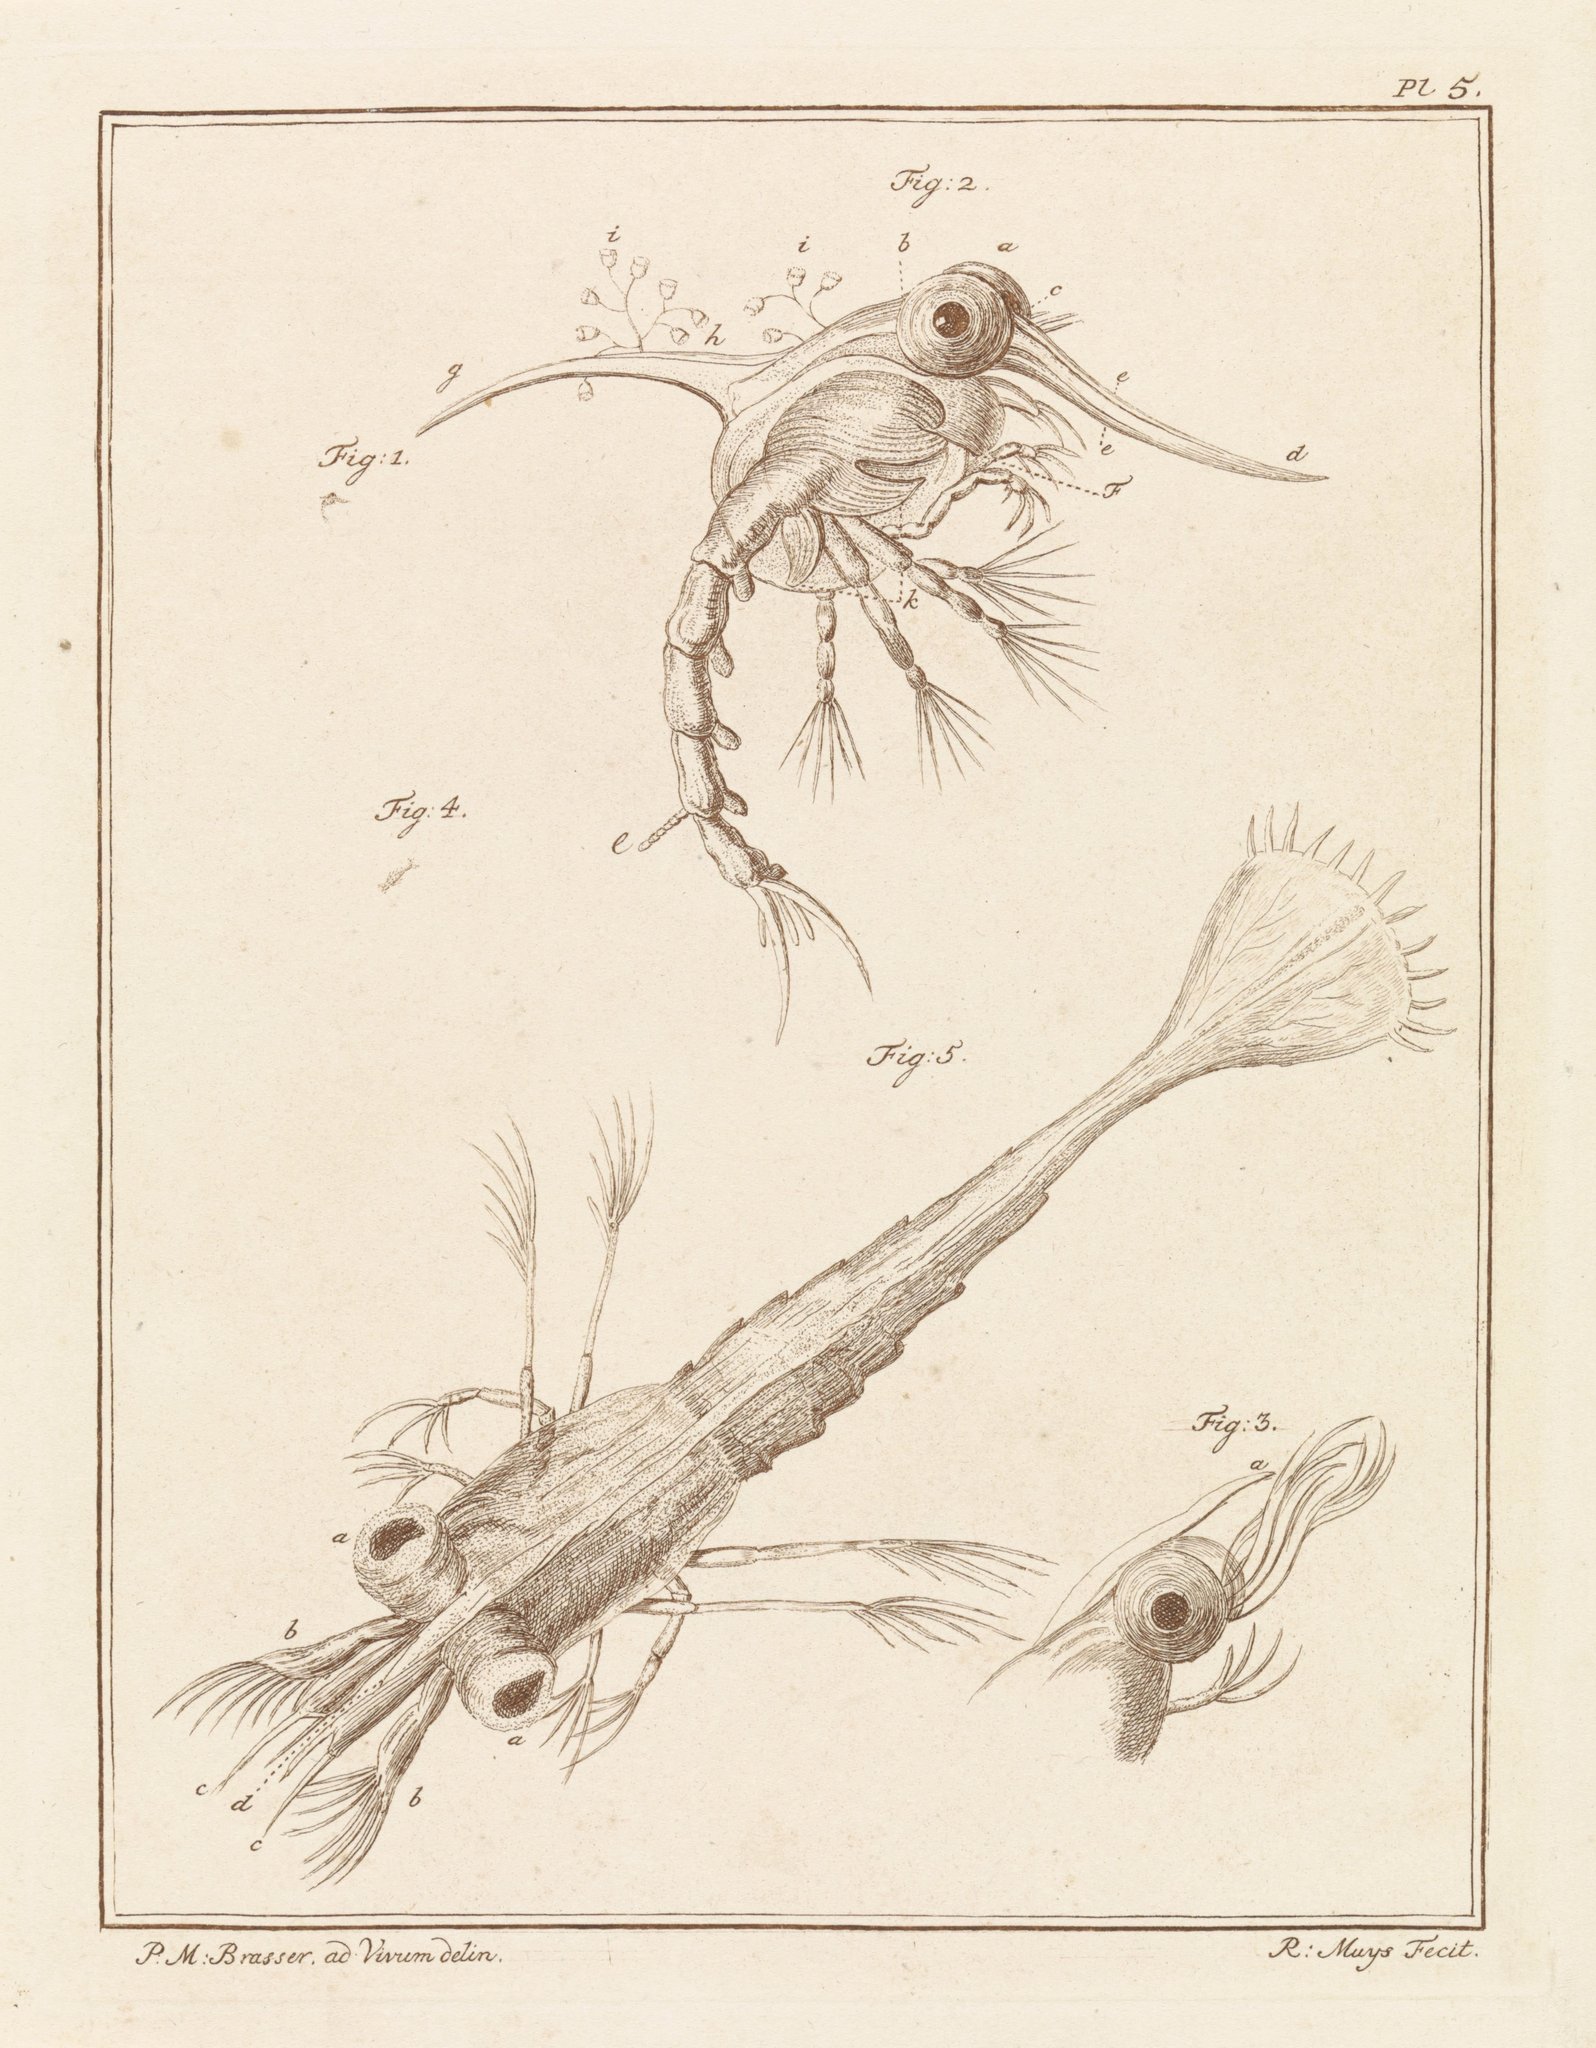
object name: book illustration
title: Twee ontwikkelingsstadia van de strandkrab larve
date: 1778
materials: paper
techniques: etching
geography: rotterdam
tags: animals (+ 'larva', grub), crustaceans: crab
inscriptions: collector's mark: Lugt 2228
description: Twee afbeeldingen van de strandkrab larve op ware grootte in twee verschillende ontwikkelingsstadia en twee uitvergrotingen. Rechtsonder een uitvergroting van de kop in het tweede ontwikkelingsstadium. Rechtsboven: Pl. 5. Prent uit een boek over binnen- en buitenlandse land- en waterdieren.